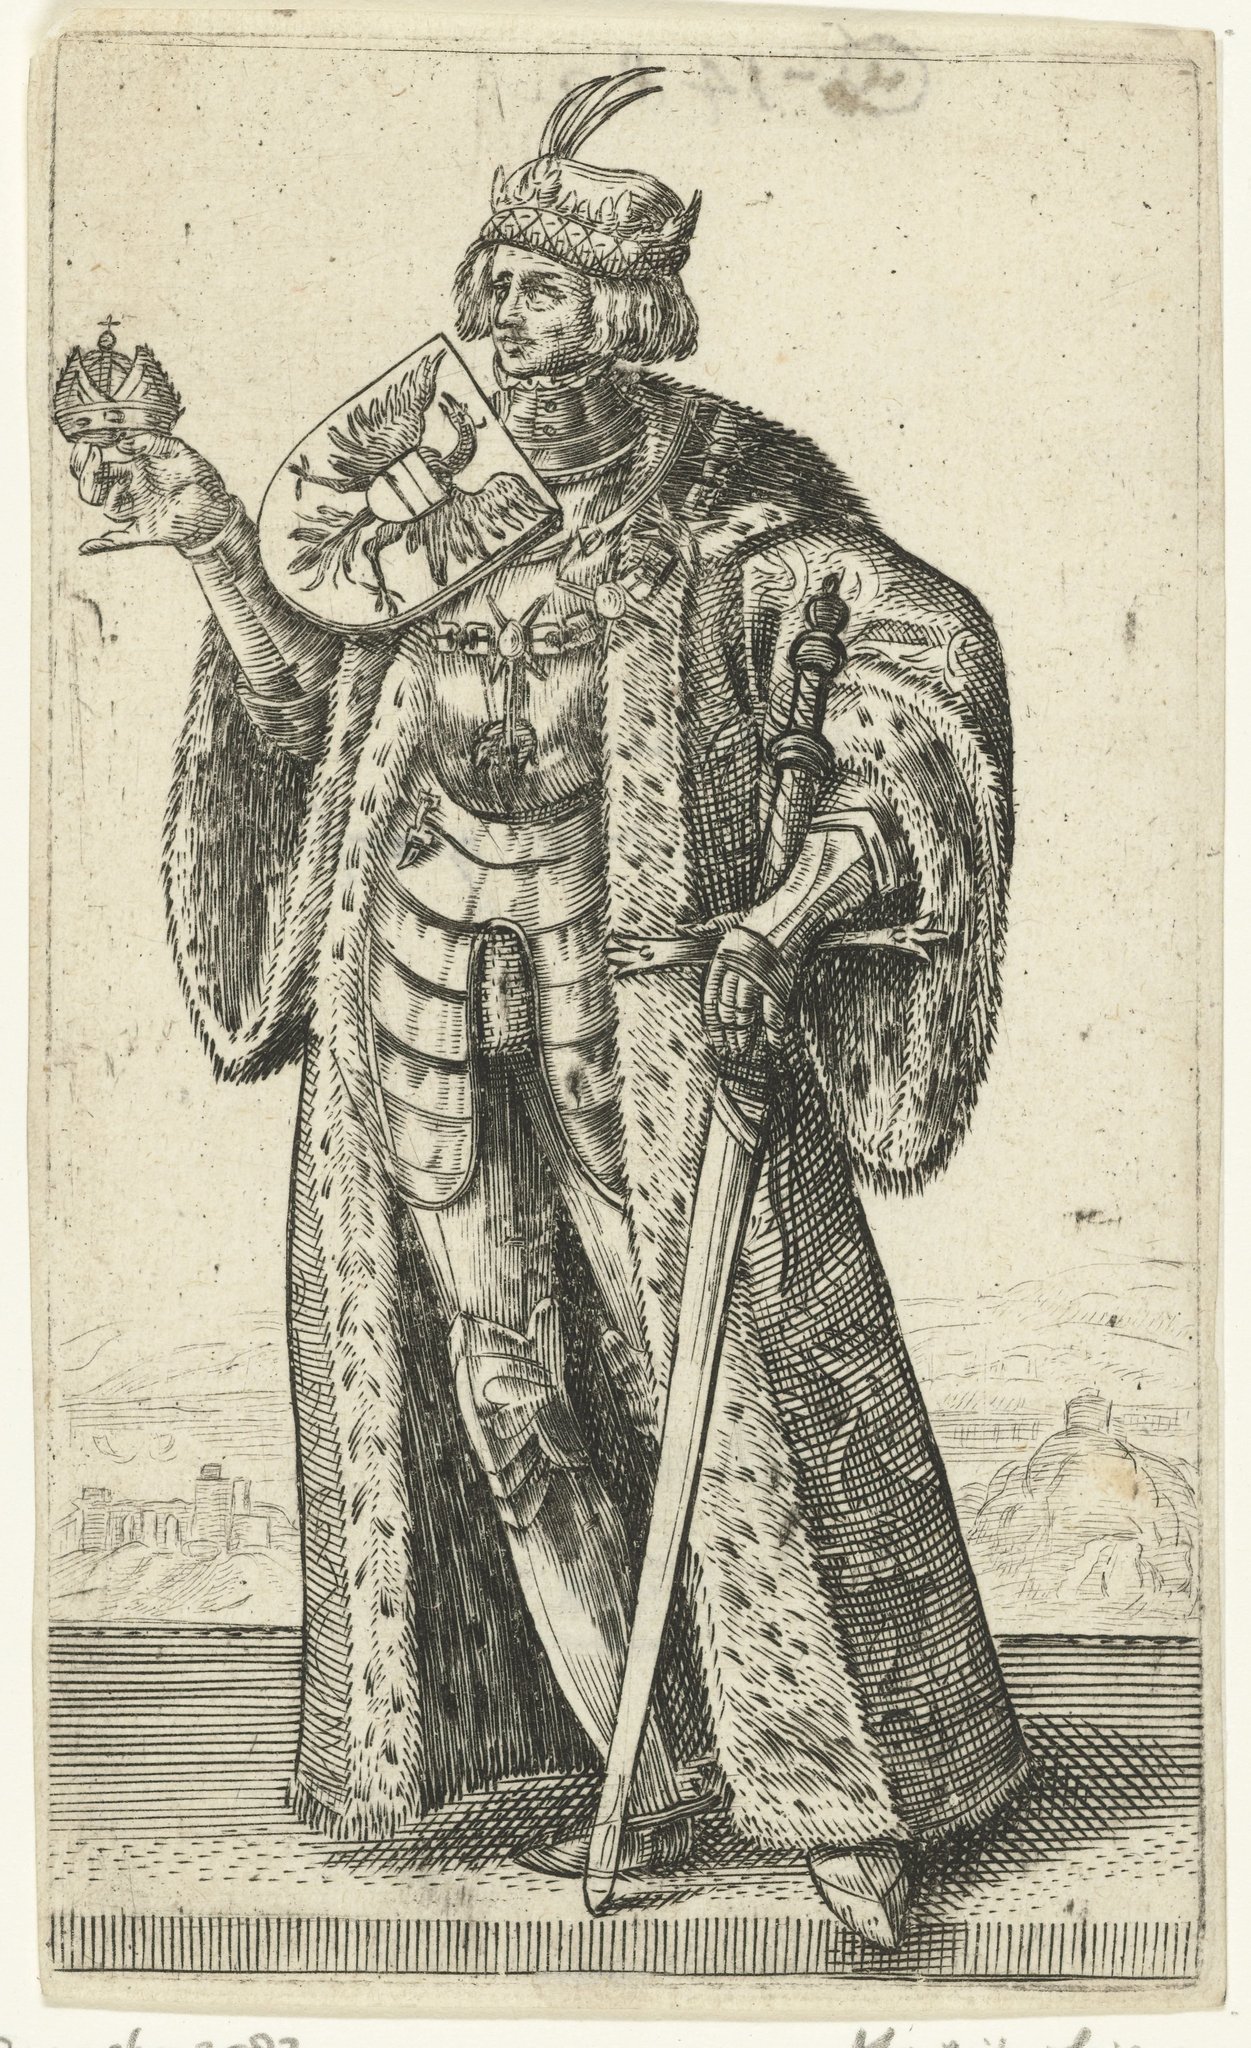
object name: print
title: Graven en gravinnen van Holland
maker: adriaen matham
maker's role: draughtsman, print maker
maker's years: 1599-1660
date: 1620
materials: paper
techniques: engraving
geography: haarlem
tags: maximilian i (holy roman emperor), nobility and patriciate; chivalry, knighthood, county of holland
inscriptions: number: ‘1482’, collector's mark: Lugt 2228, name: ‘maximiliaan/ 28ste graaf’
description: Portret van Maximiliaan I van Habsburg, Rooms-Duits keizer, staande met wapenschild, zwaard en in zijn hand een kroon. Prent uit een serie van 36 prenten met portretten ten voeten uit van graven en gravinnen van Holland.